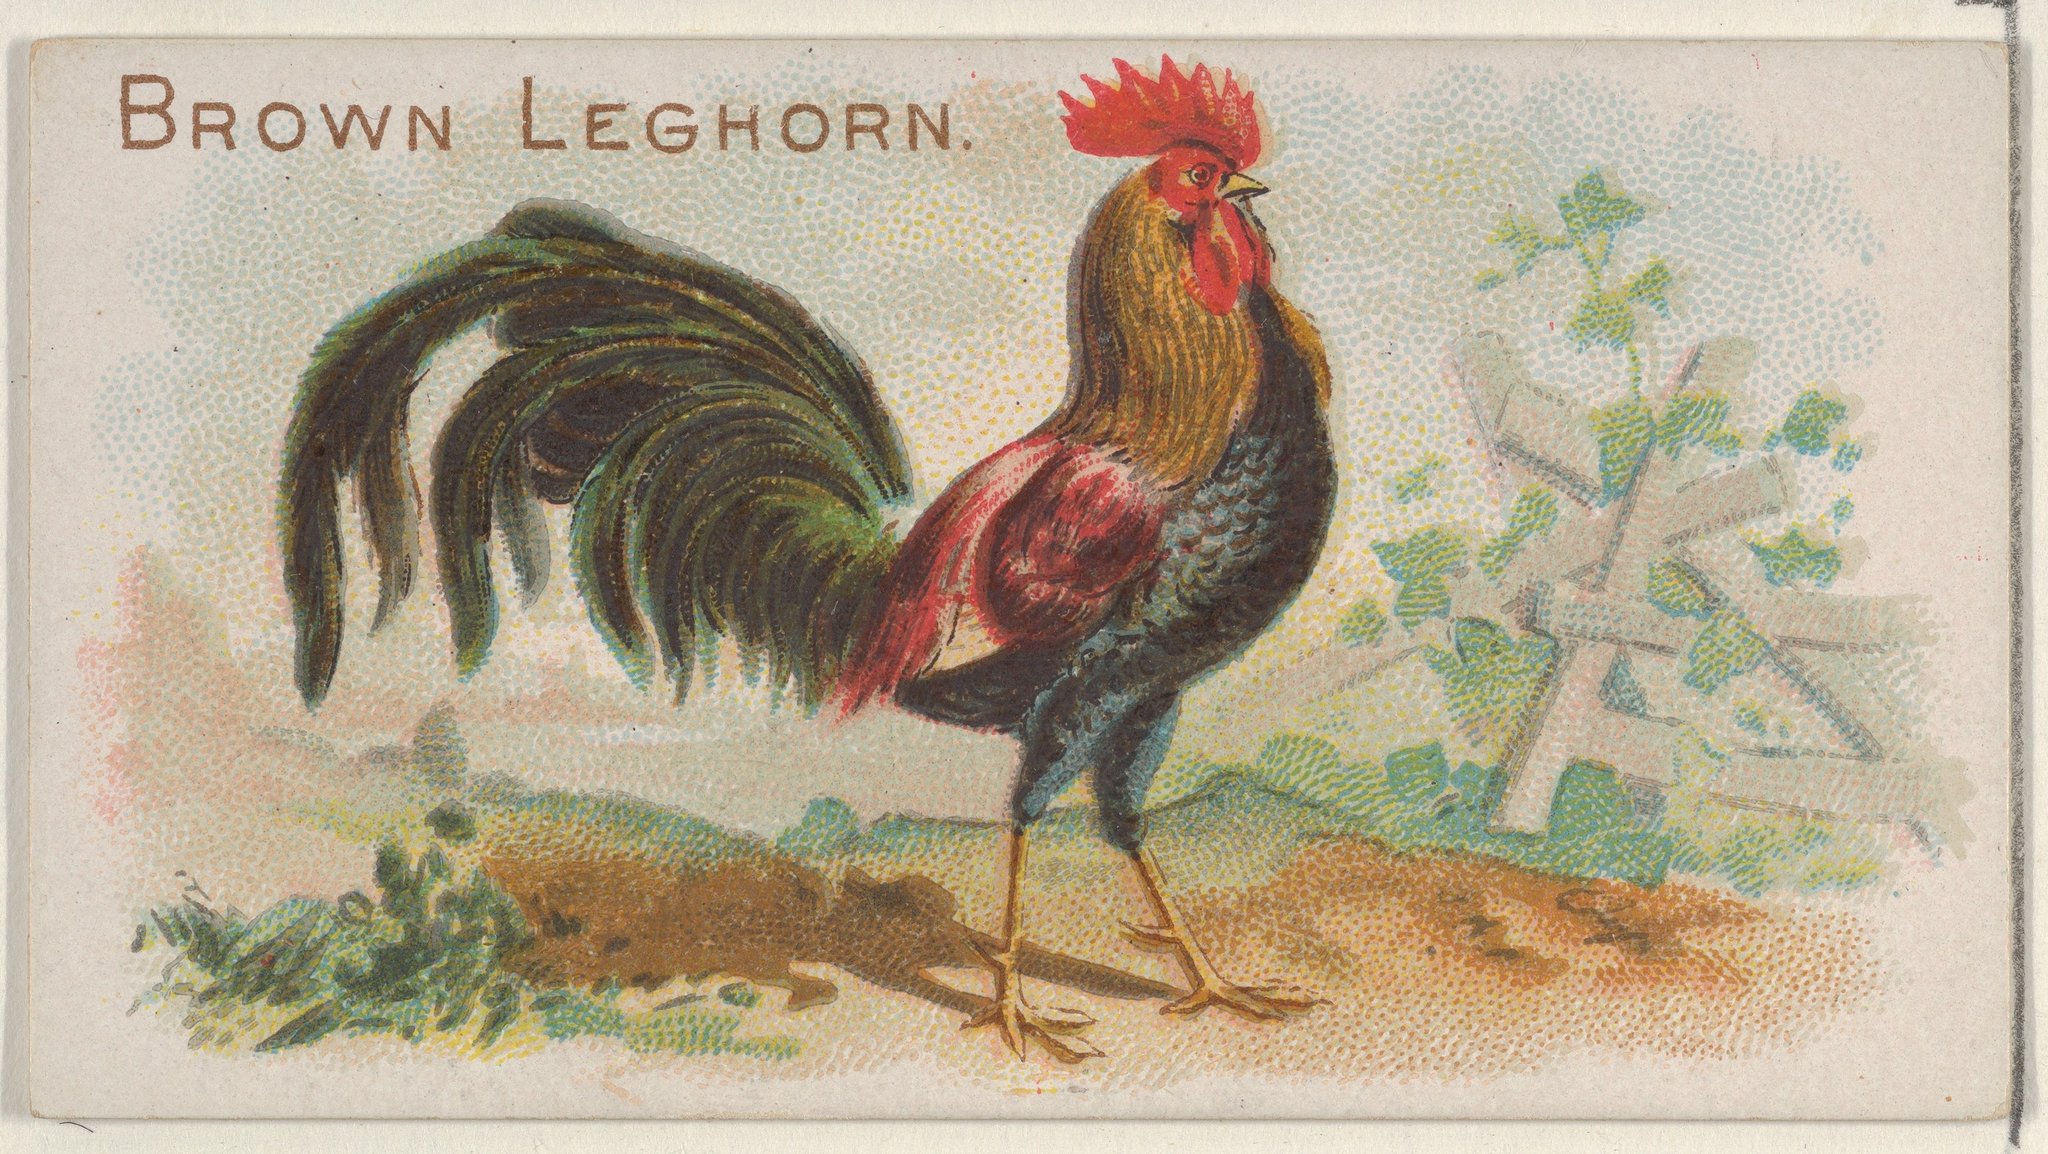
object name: print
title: Brown Leghorn, from the Prize and Game Chickens series (N20) for Allen & Ginter Cigarettes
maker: allen & ginter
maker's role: publisher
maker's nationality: american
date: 1891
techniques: color lithograph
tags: chickens